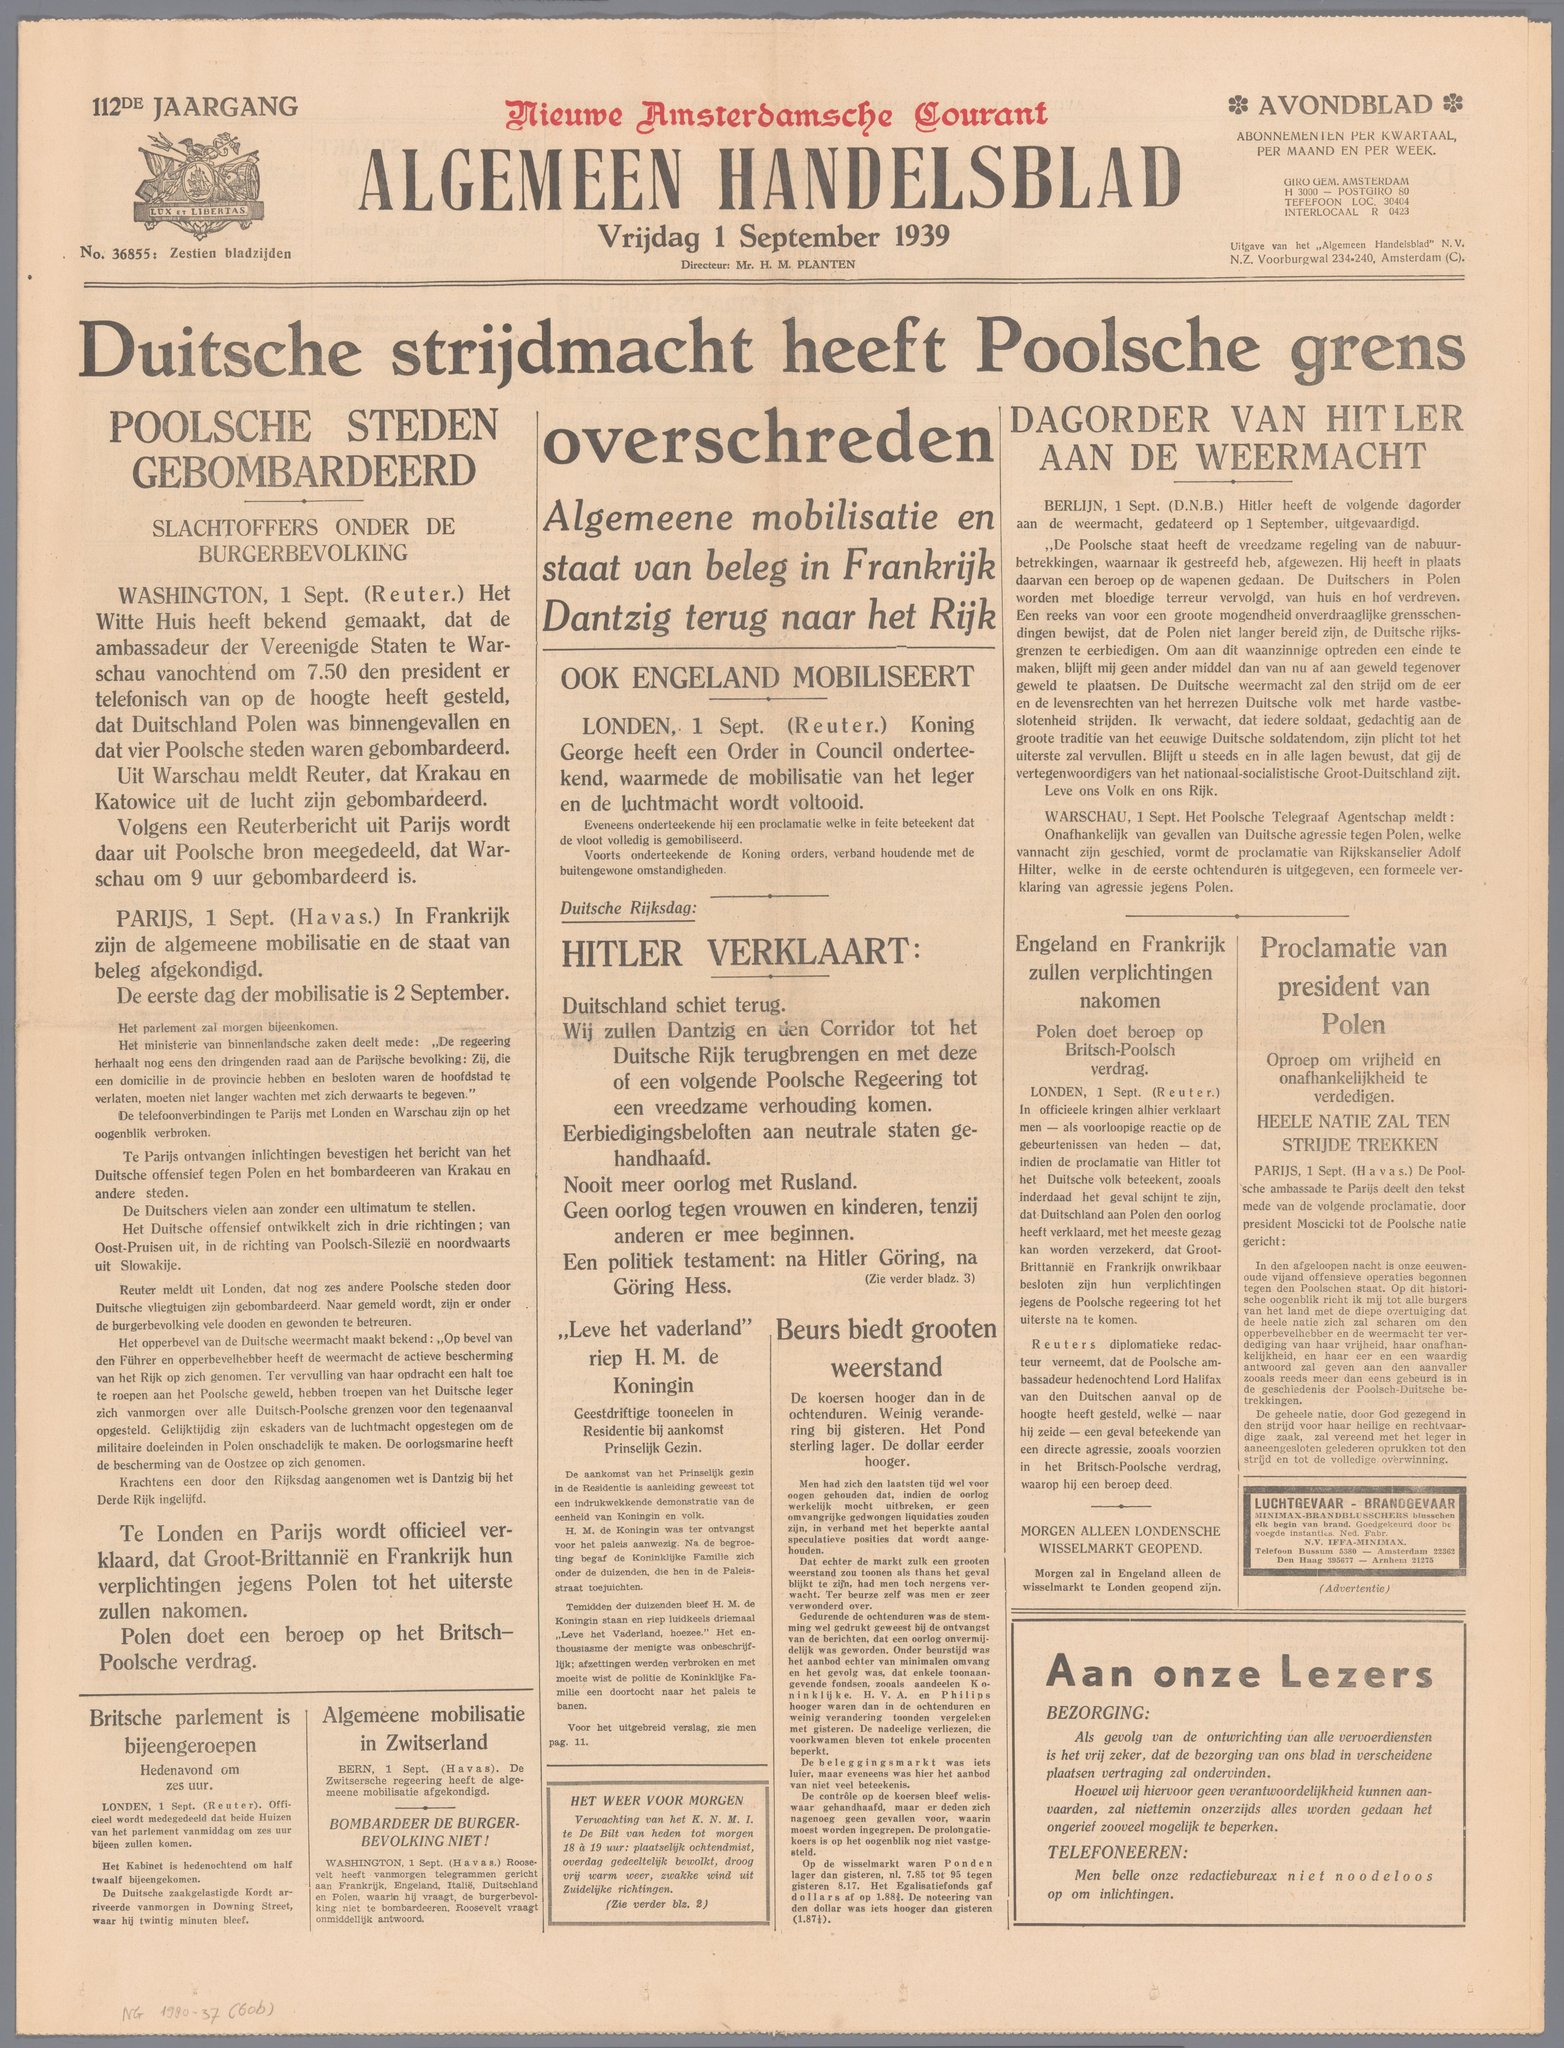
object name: newspaper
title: Algemeen Handelsblad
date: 1939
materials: paper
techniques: printing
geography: amsterdam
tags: poland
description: Krant over de duitse invasie in Polen, 8 pp (van 16) nr. 36855 van de 112e jaargang van de Algemeen Handelsblad.